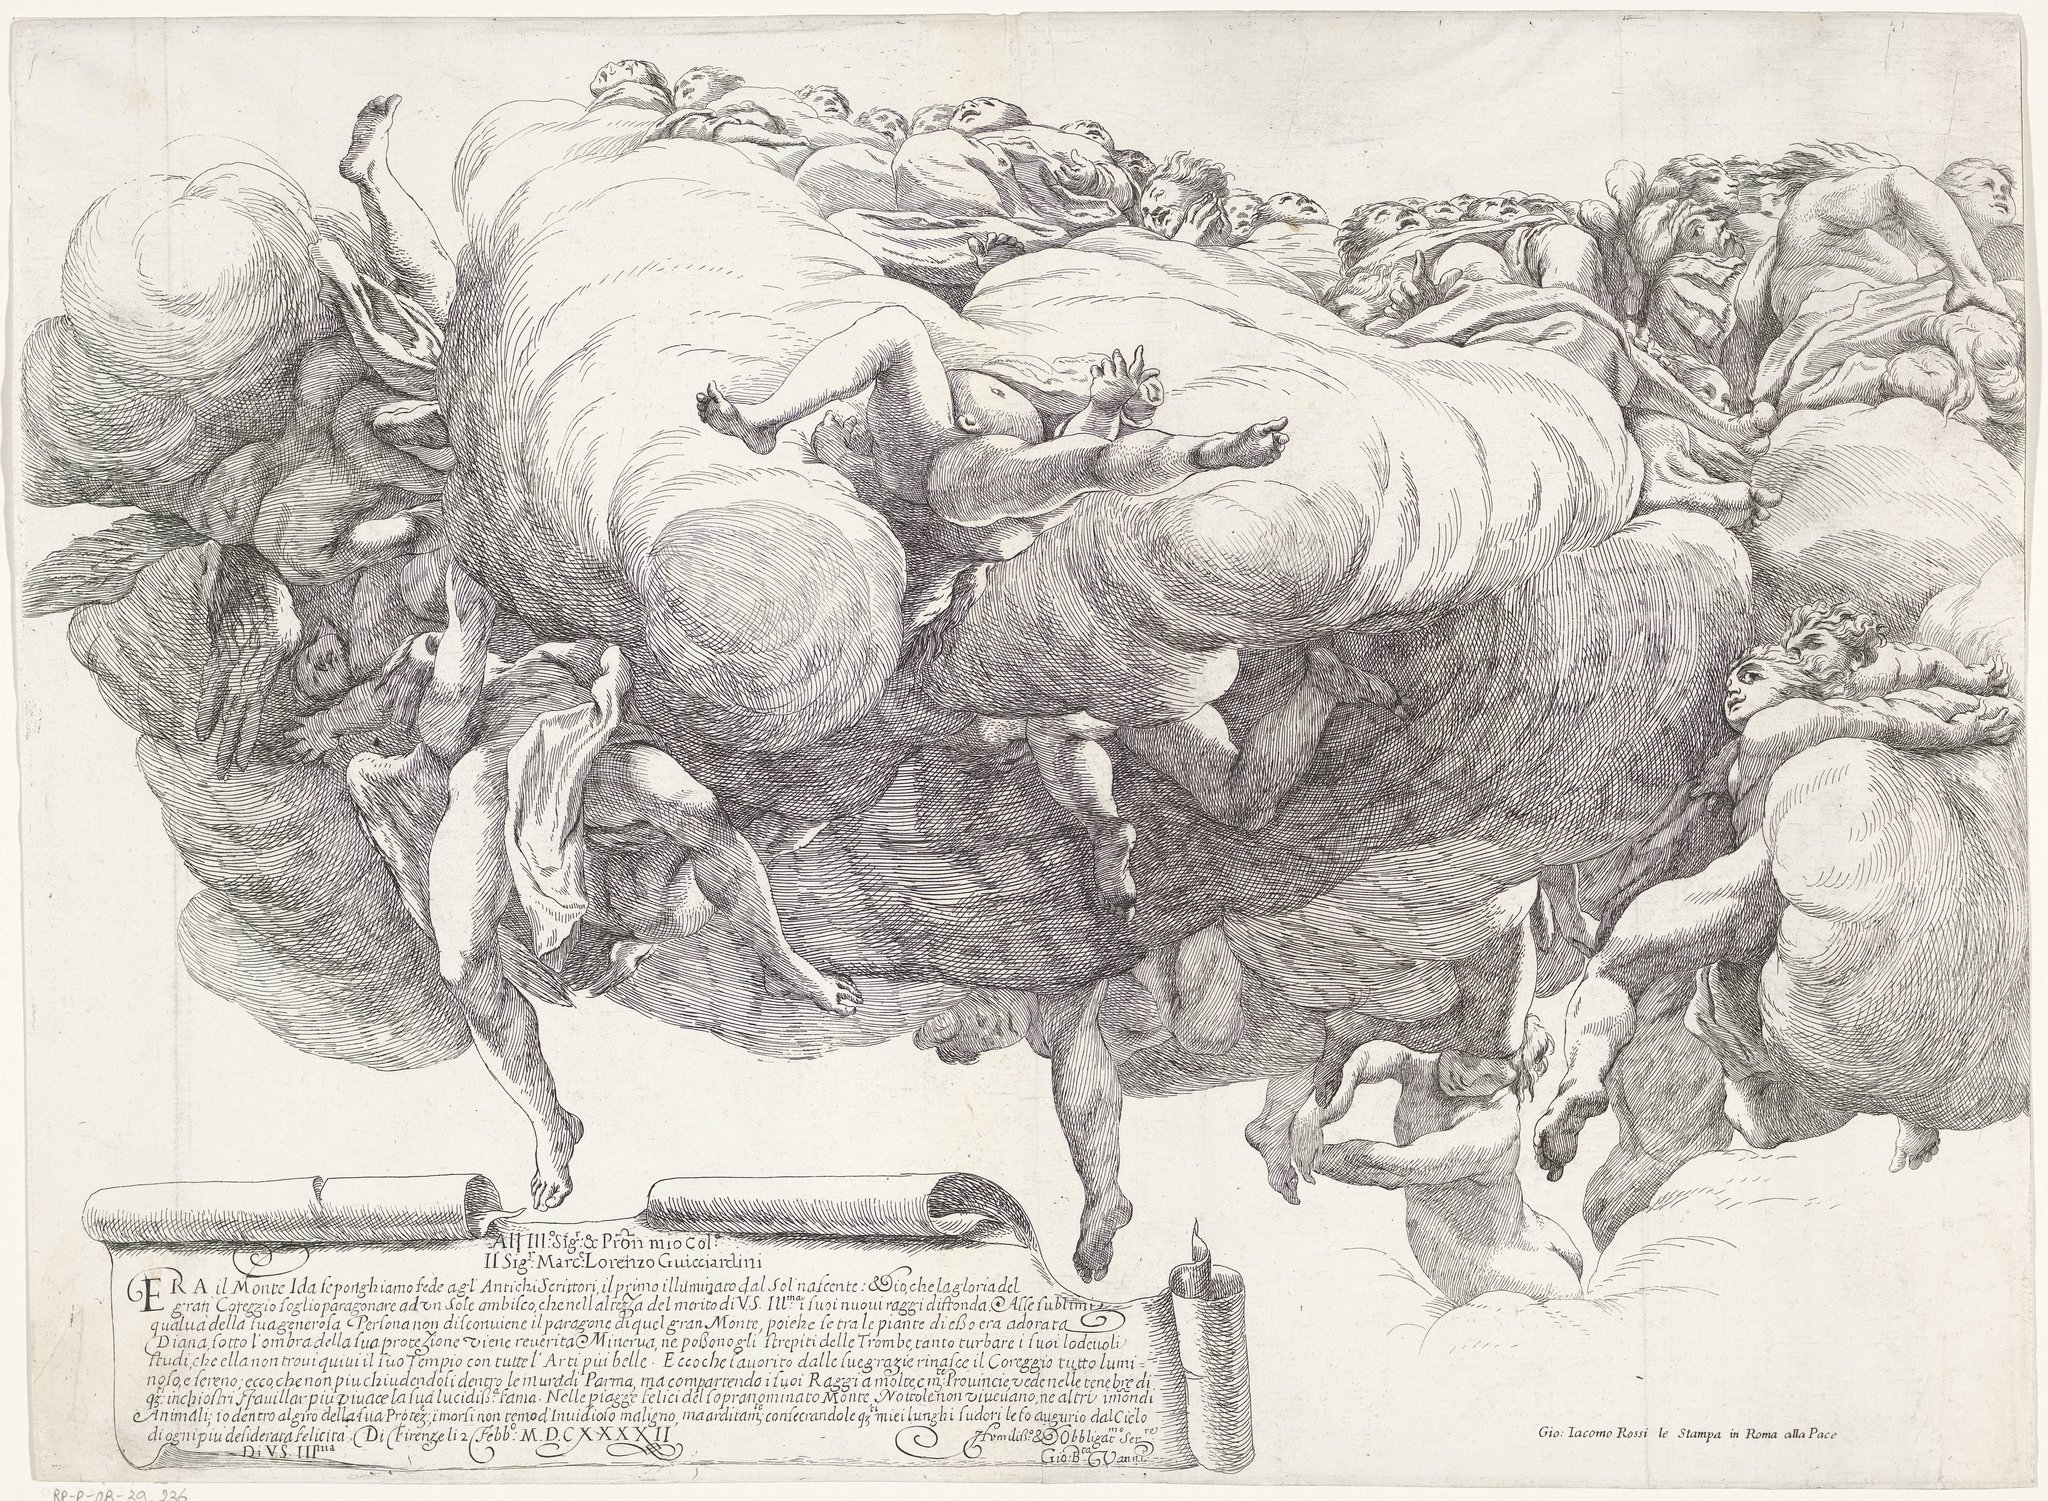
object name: print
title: Hemelvaart van Maria (linker deel)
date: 1642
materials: paper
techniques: etching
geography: parma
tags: the assumption of mary ('assumptio corporis'): she is borne into heaven by angels, cupids: 'amores', 'amoretti', 'putti'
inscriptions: collector's mark: Lugt 240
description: Putti tussen wolken. Linksonder een banderol met opdracht in het Italiaans.